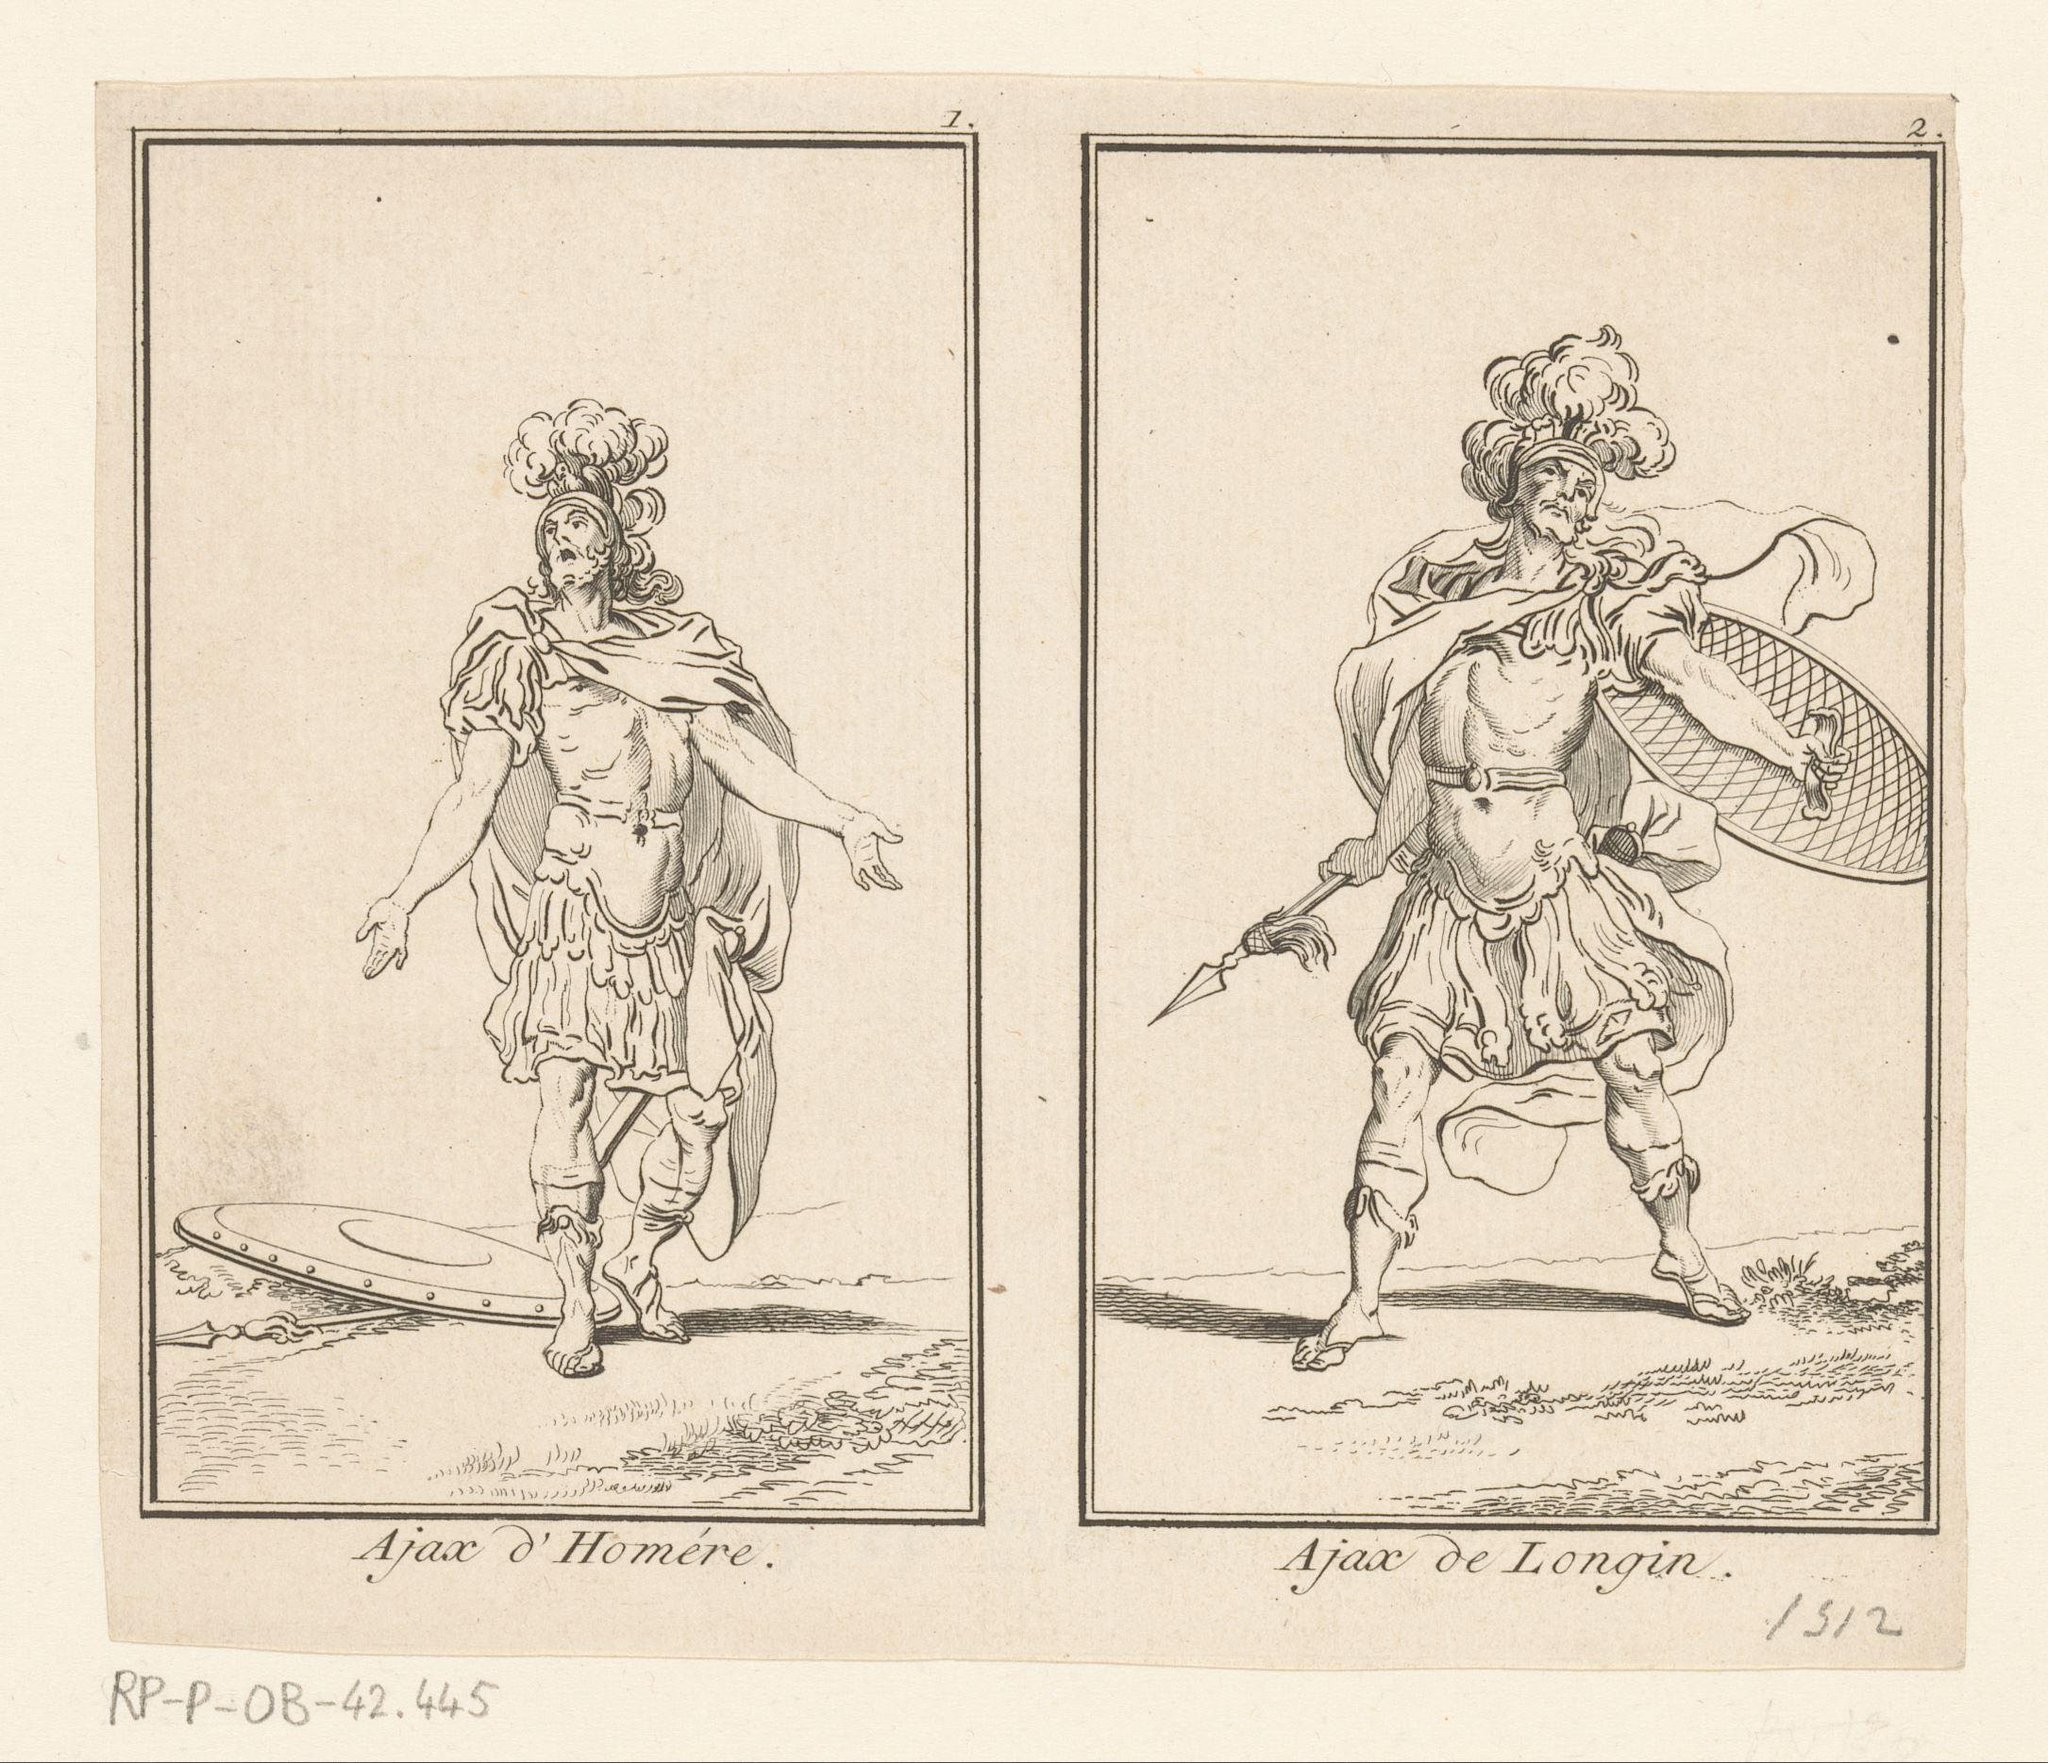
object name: print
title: Twee afbeeldingen van Ajax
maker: laurent cars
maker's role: print maker, publisher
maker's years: 1699-1771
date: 1709-1771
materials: paper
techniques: etching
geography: france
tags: ajax the great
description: Prent uit: Sibert, Gautier de. Catalogue des Chevaliers, Commandeurs et Officiers de l'ordre du Saint-Esprit. Parijs: C.J.F. Baltard, 1760, p.